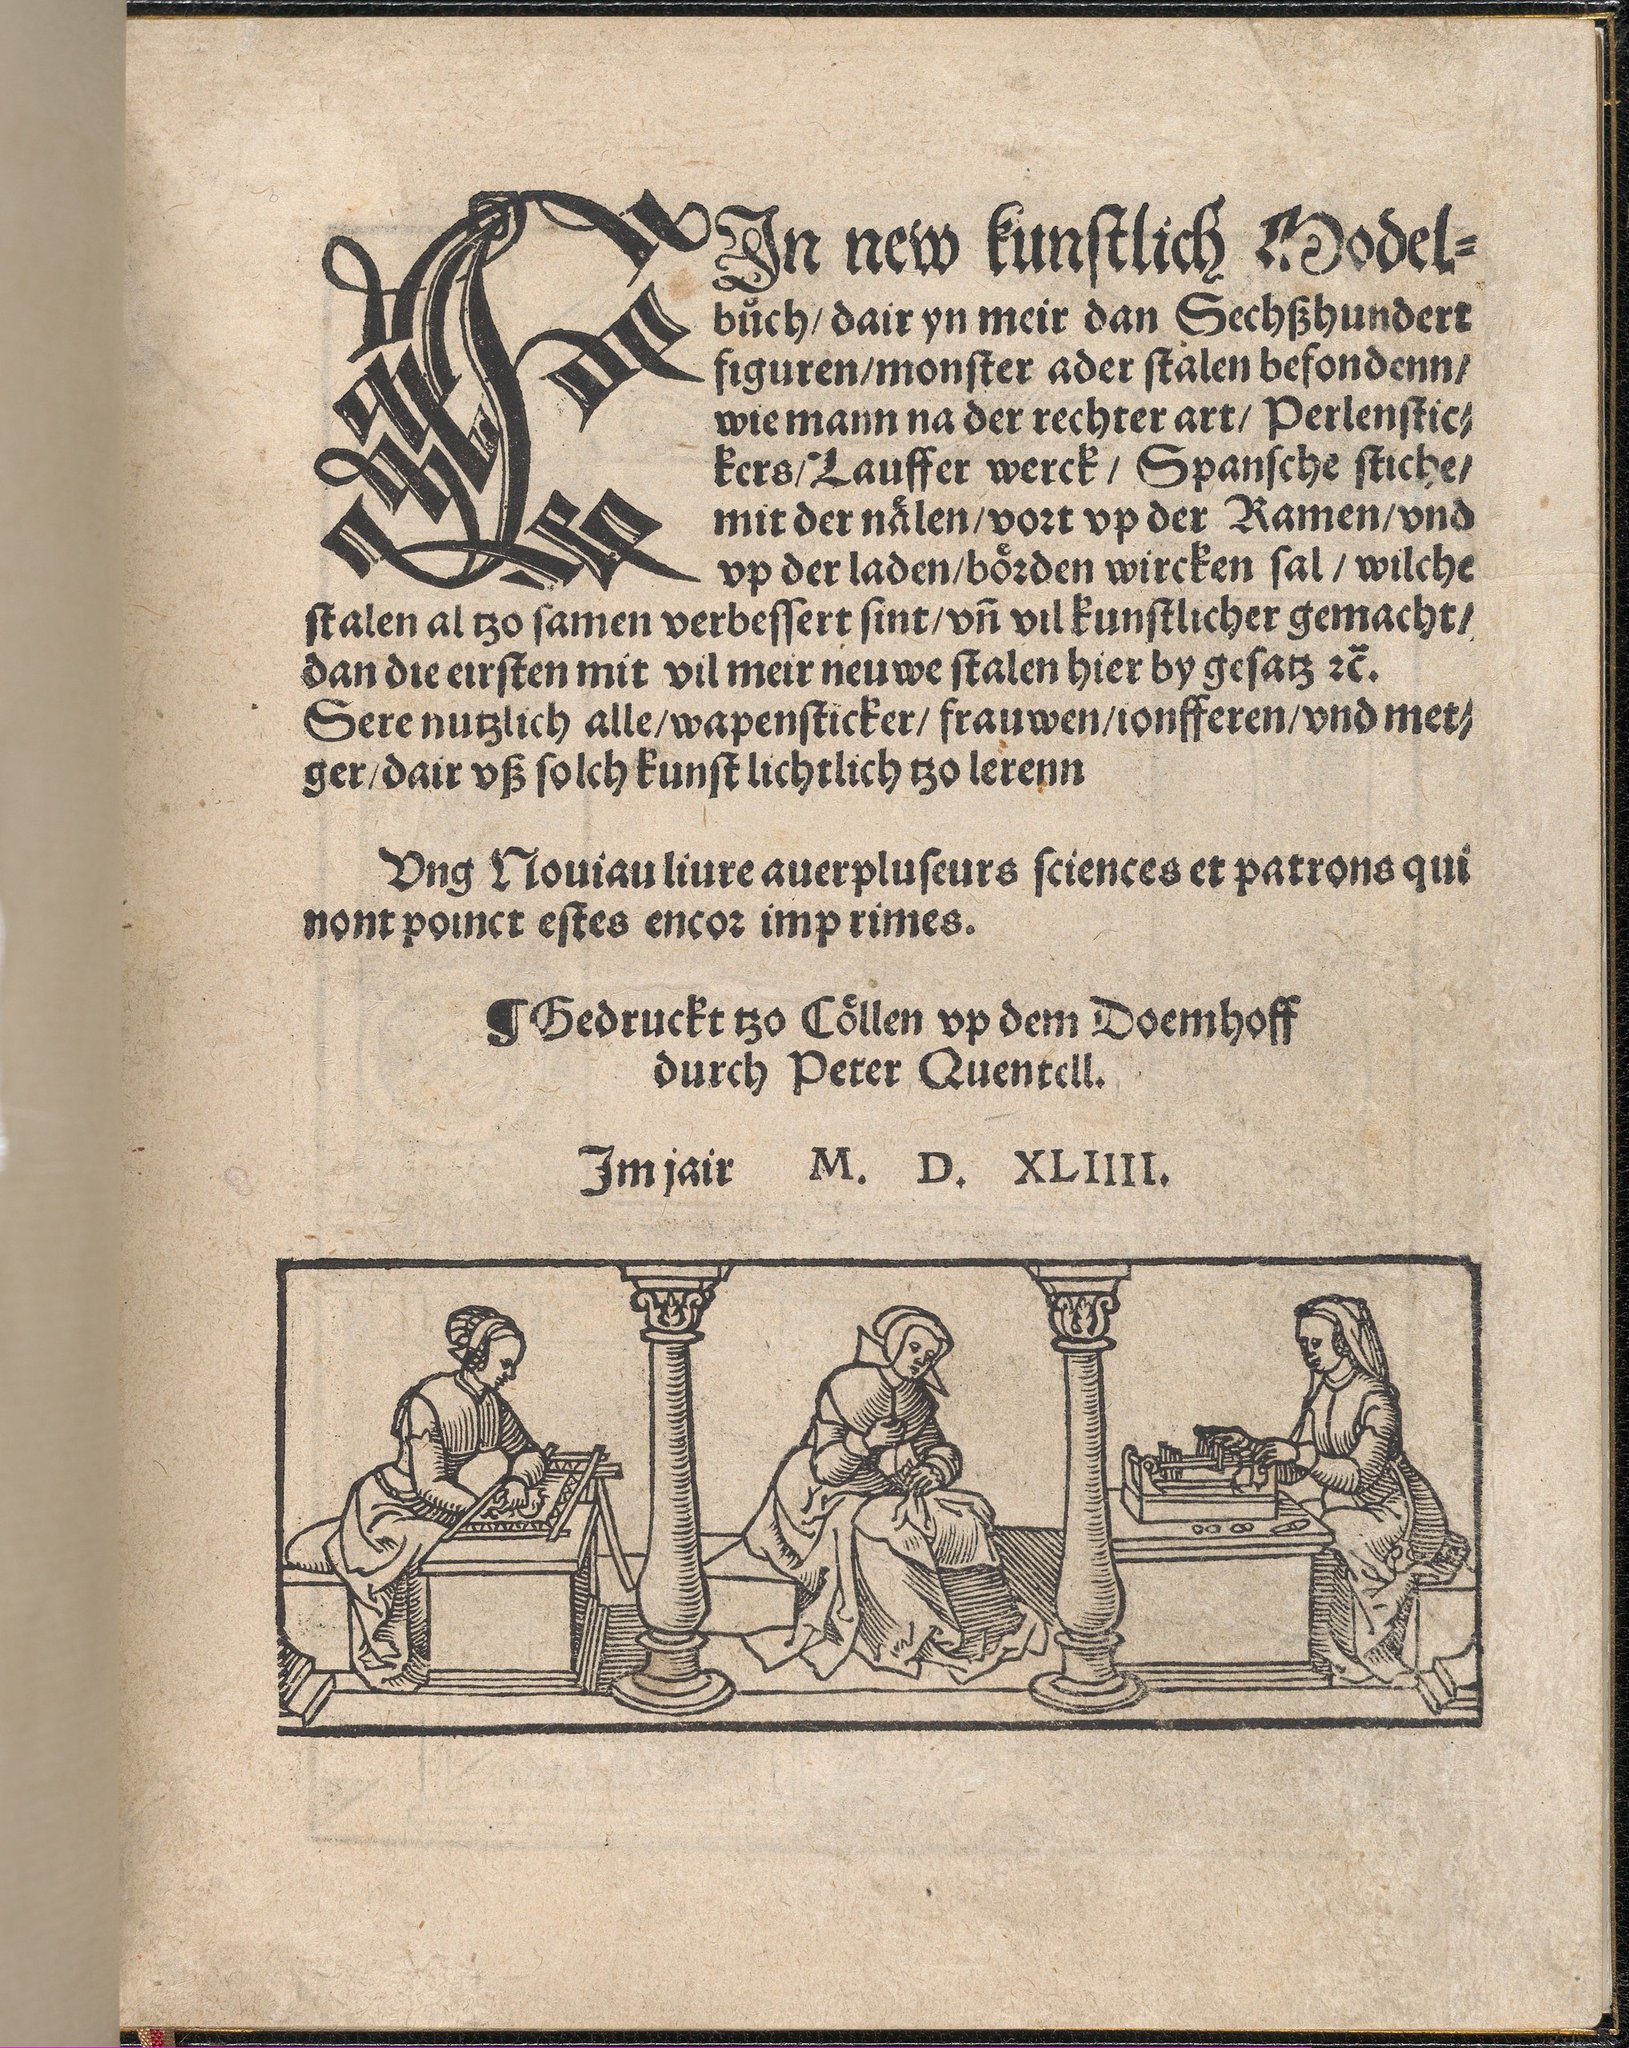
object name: book print ornament architecture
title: Ein new kunstlich Modelbuch...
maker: peter quentel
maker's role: publisher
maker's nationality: german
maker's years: 1500-1550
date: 1544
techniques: woodcut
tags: women